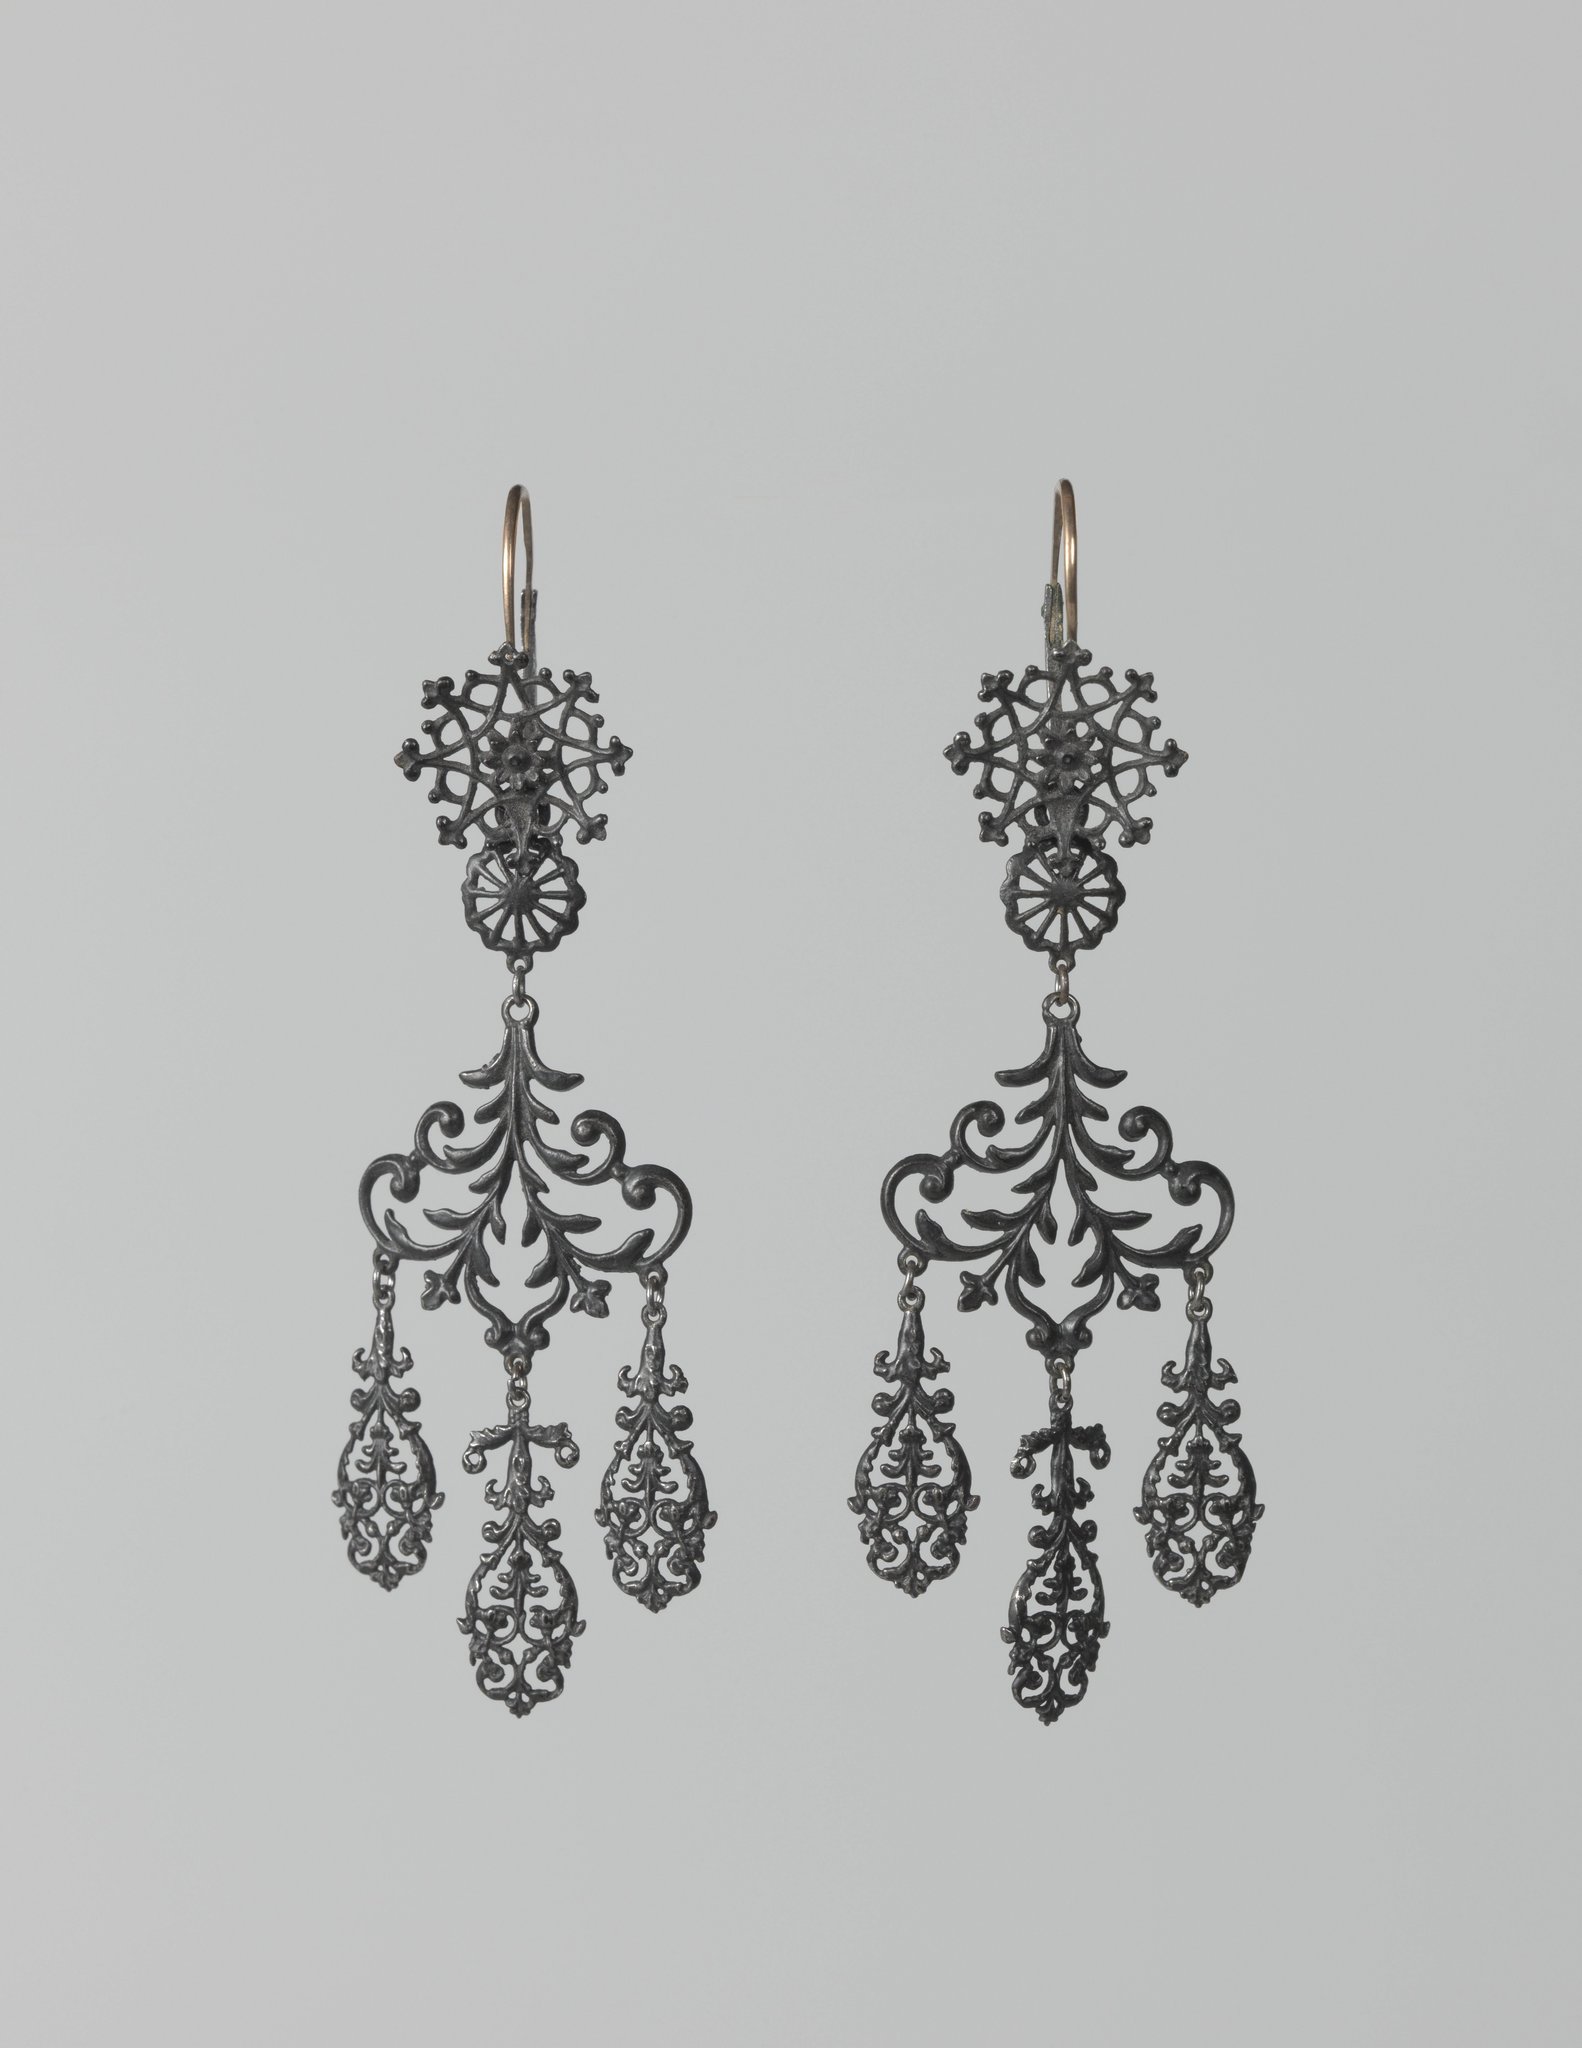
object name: ear ornament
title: Een paar oorhangers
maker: Anonymous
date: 1815-1835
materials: gold, iron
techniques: casting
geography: germany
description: Een paar oorhangers van 'Fer de Berlin'. Aan een gouden oogje, haakt een opengewerkte zwarte ster. Hieronder hangen delen, bestaande uit een veerpalmet en drie aan oogjes bengelende opengesneden bladranken.